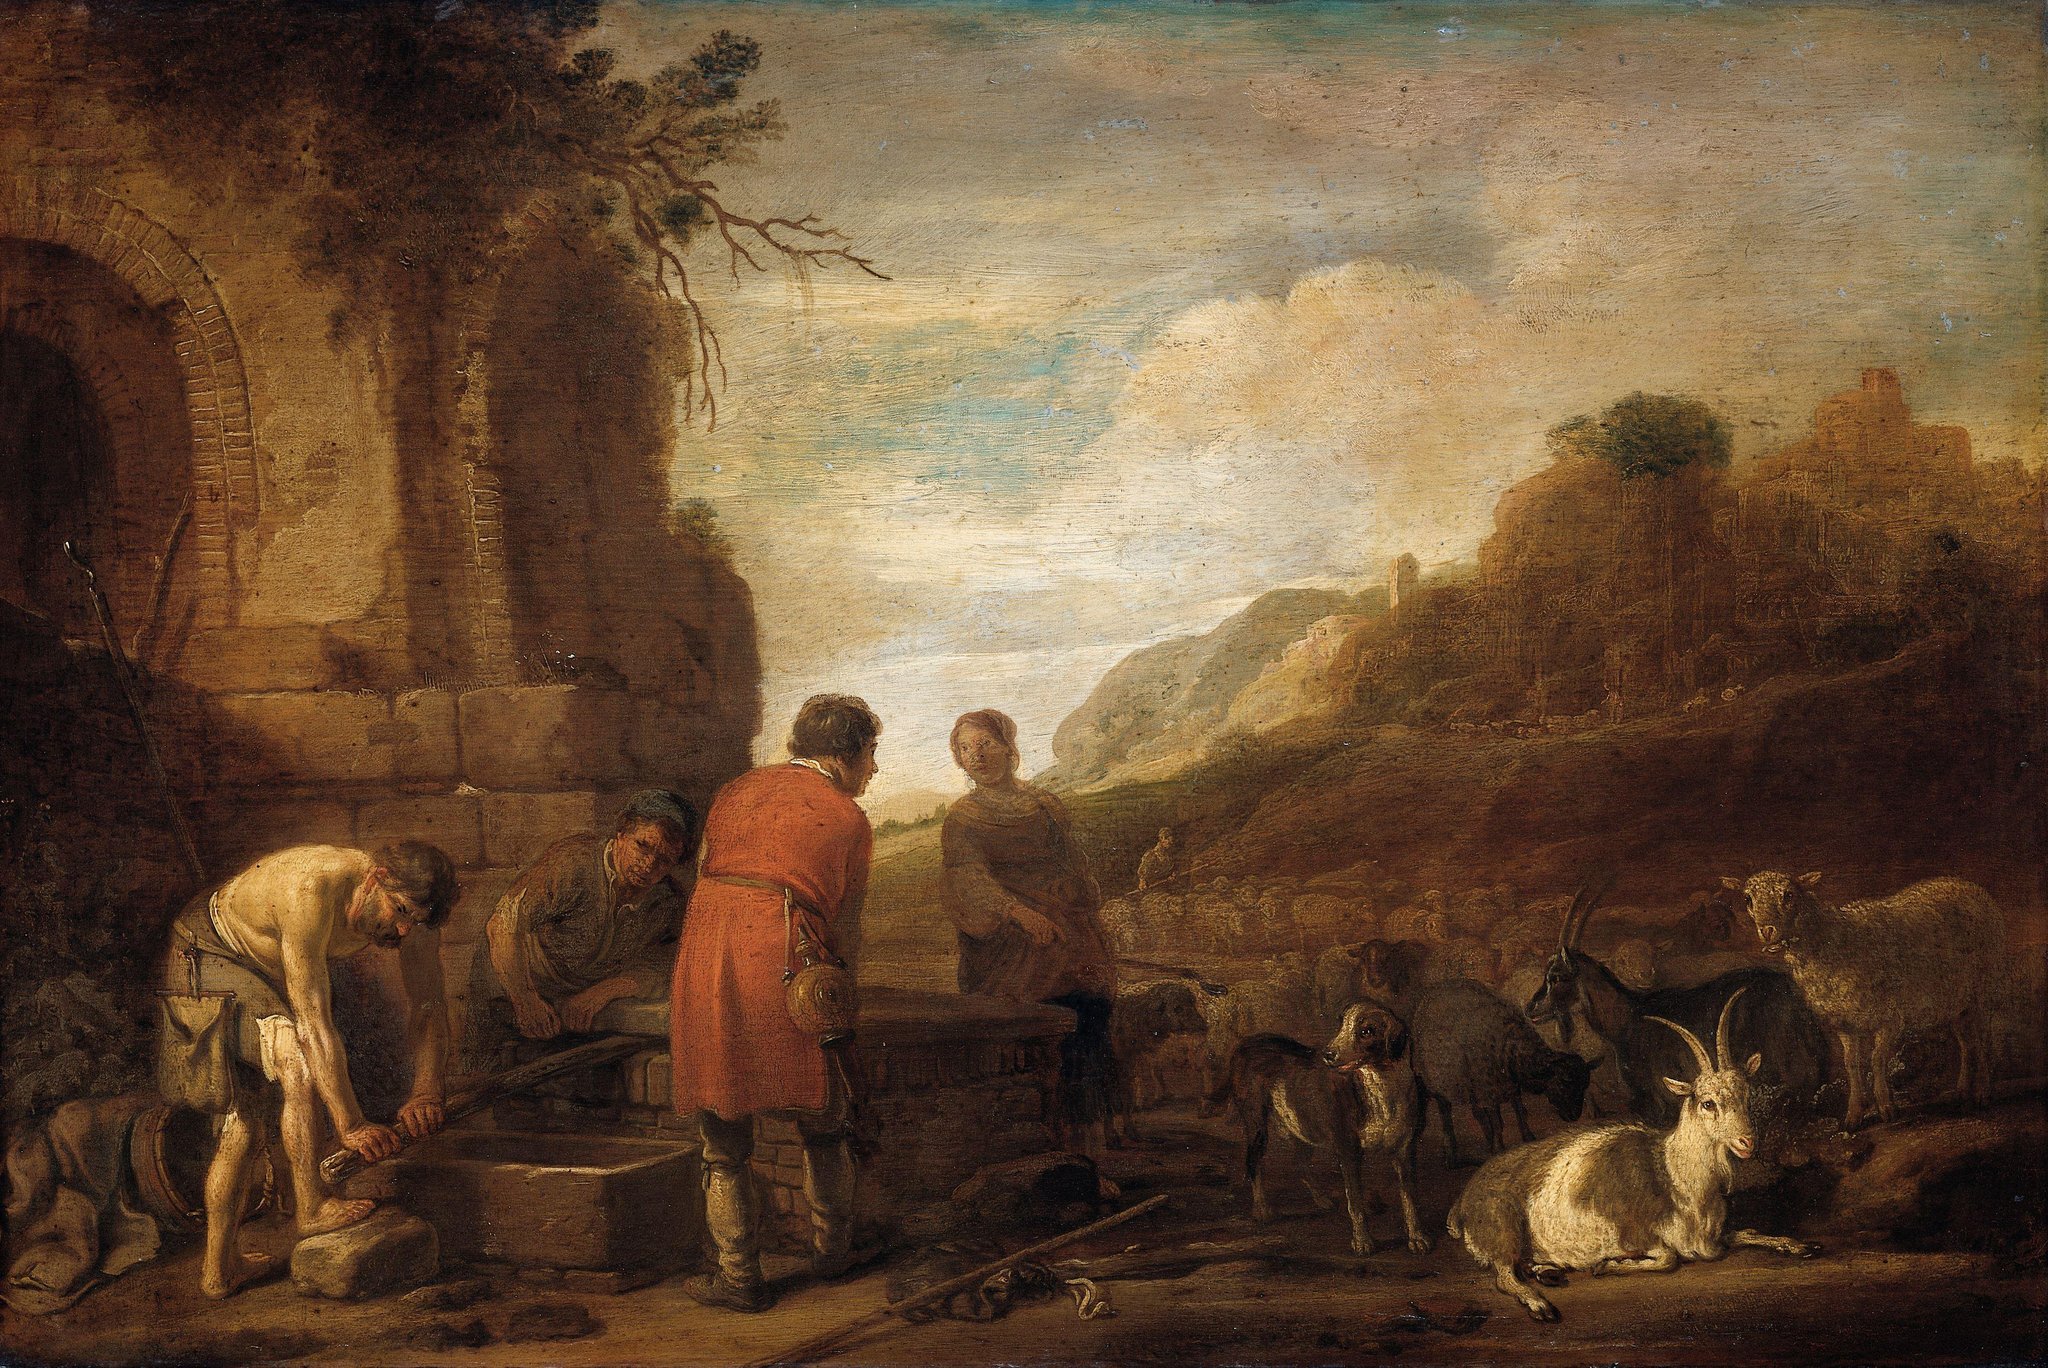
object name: painting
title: The Meeting of Jacob and Rachel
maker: claes moeyaert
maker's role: draughtsman, painter, print maker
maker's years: 1592-1655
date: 1638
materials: oil, panel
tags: jacob moves the stone which covers the opening of the well and waters rachel's sheep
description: De ontmoeting van Jacob en Rachel bij de bron. Jacob, die met twee herders een steen van de put afwentelt, spreekt tot Rachel, die met de kudde van haar vader naar de bron gekomen is, Links een ruïne, rechts geiten, schapen en een hond.